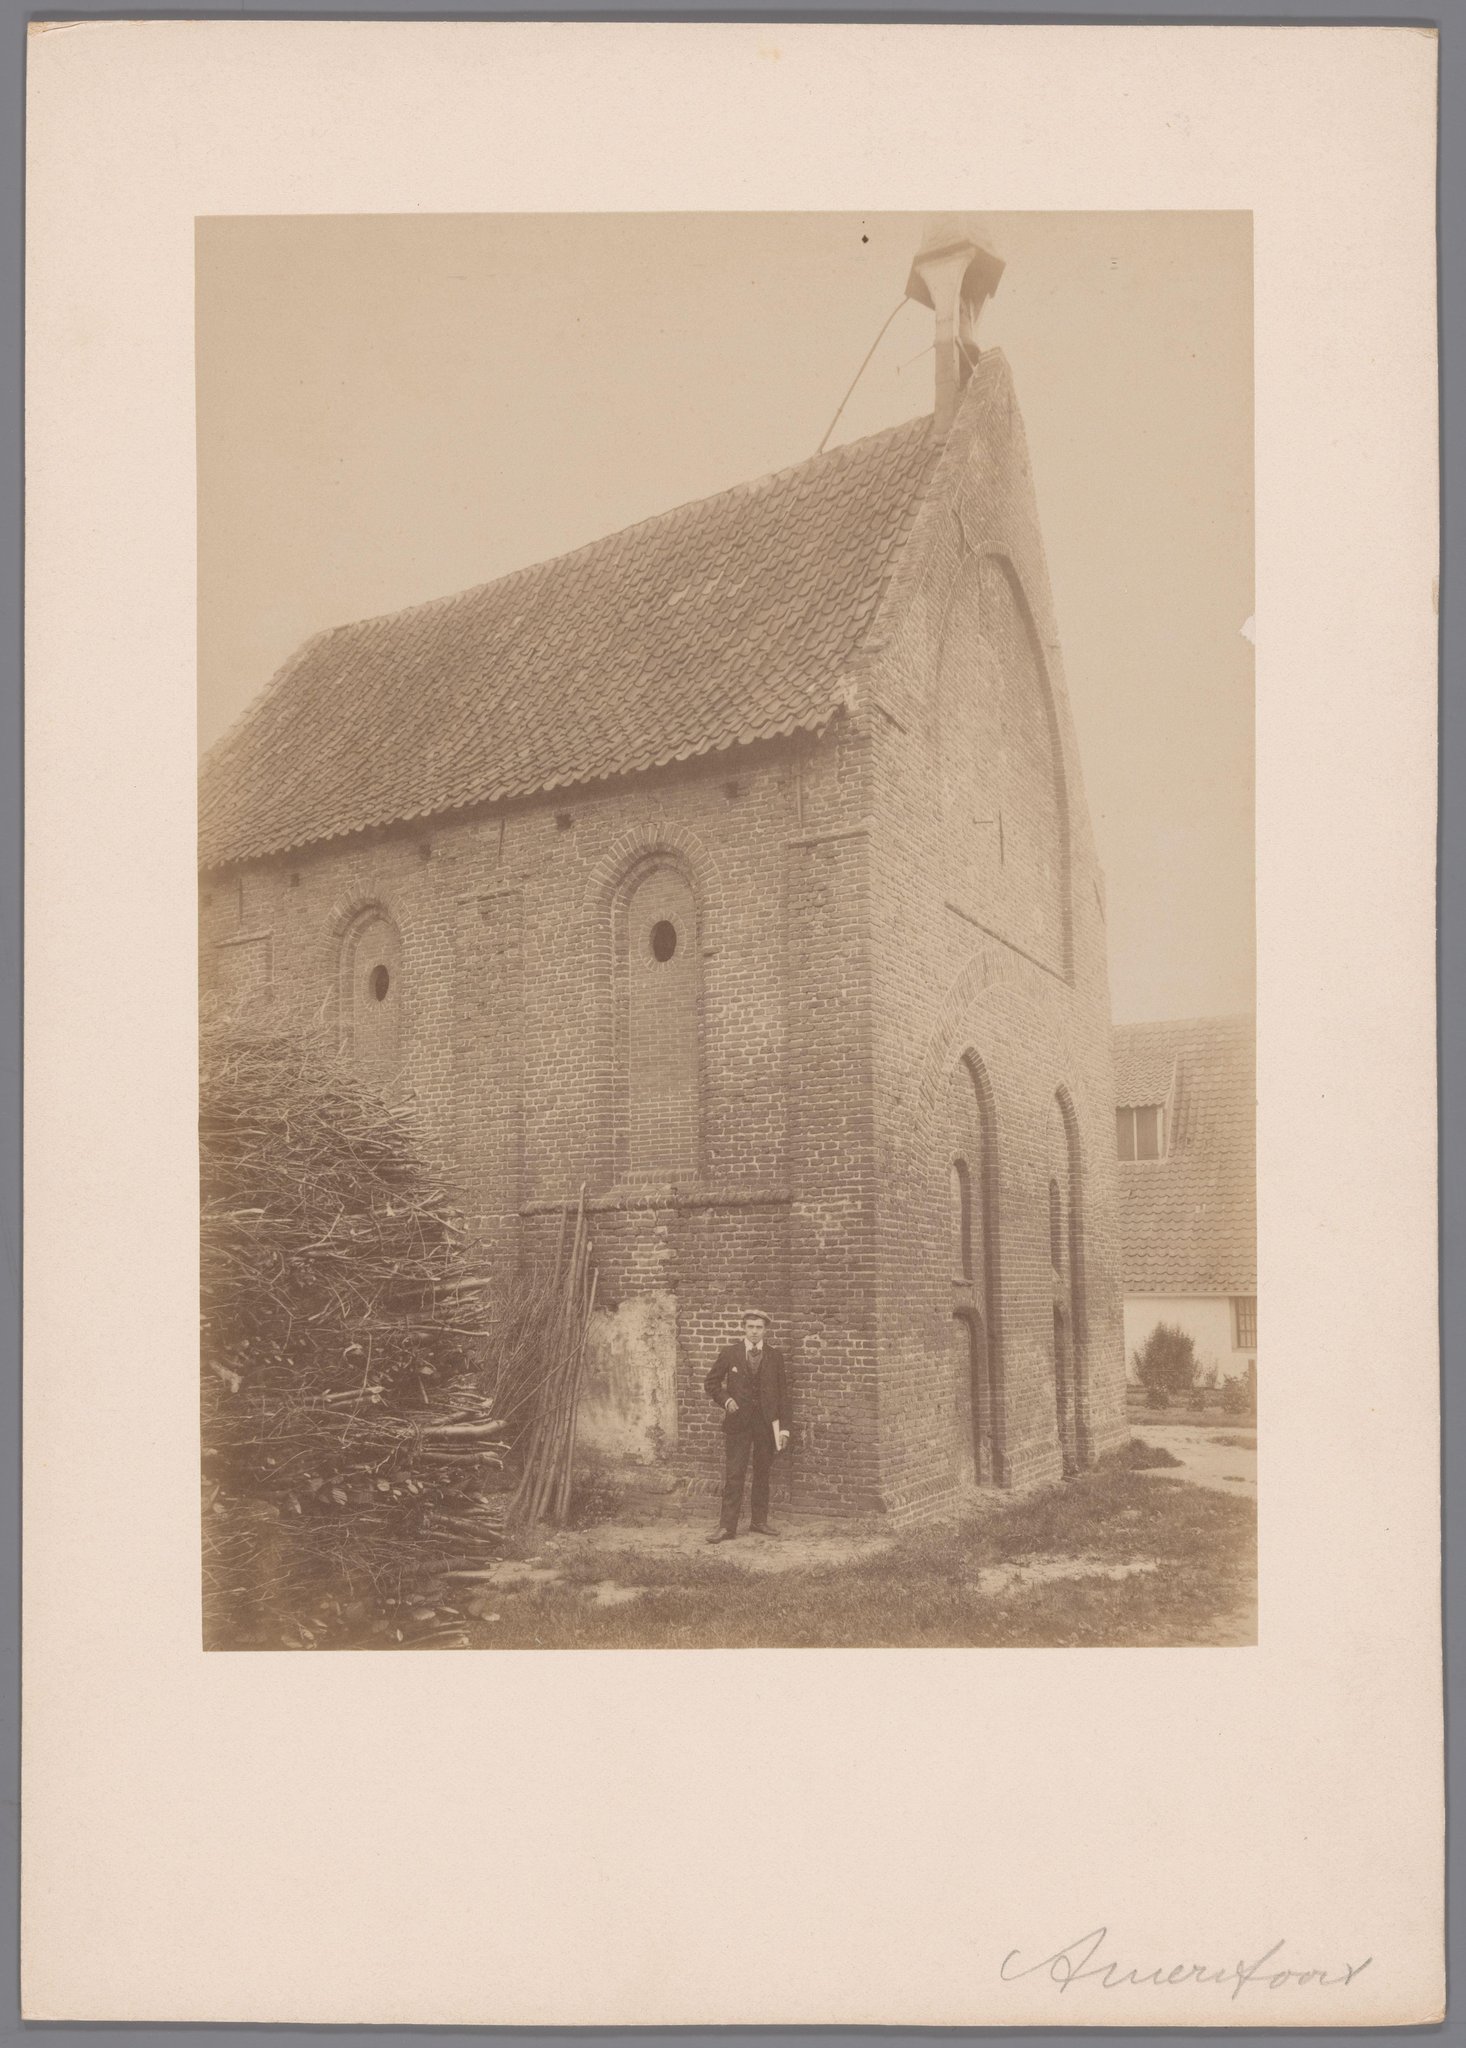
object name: photograph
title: Sint-Rochuskapel bij het gasthuis te Amersfoort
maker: anoniem (monumentenzorg)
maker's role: fotograaf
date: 1902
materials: cardboard, photographic support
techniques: albumen print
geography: amersfoort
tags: parts of church exterior and annexes: chapel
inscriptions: annotation: ‘Amersfoort/ st. Rochus Kapel in het armengesticht "de Poth"/ 1902’, annotation: ‘Amersfoort’